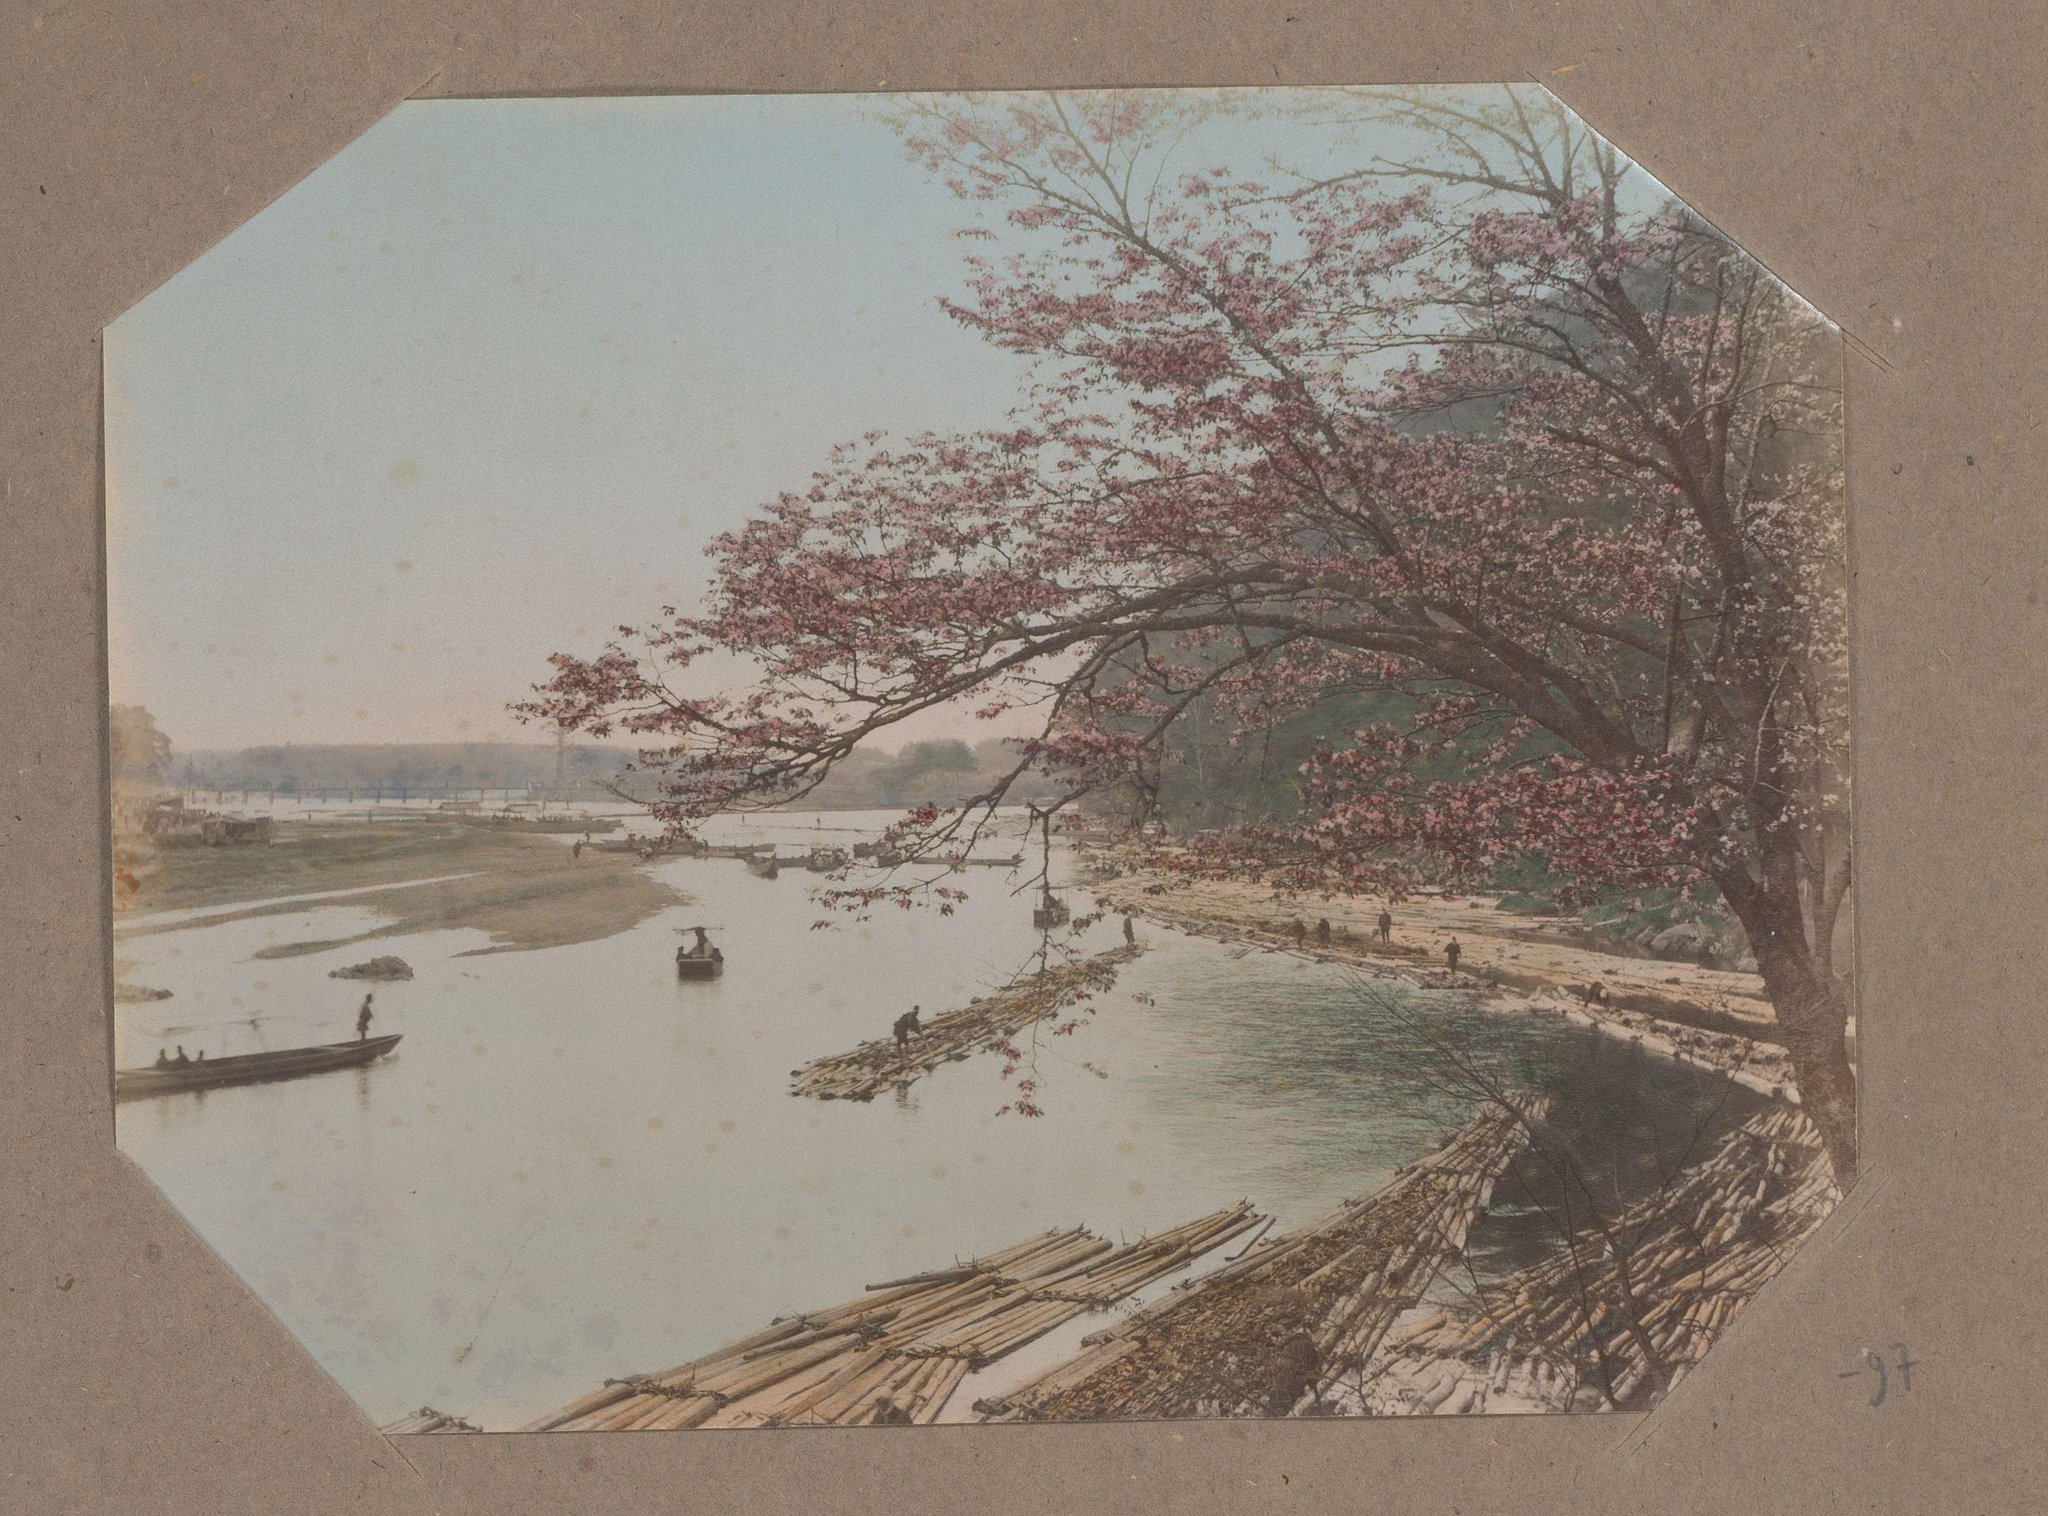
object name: photograph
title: Kersenbloesem op de oever van een rivier met bamboevlotten in Japan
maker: Anonymous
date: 1890-1903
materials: paper, photographic support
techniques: albumen print, hand coloring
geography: japan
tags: trees: cherry-tree, traffic on the water, river bank (+ landscape with figures, staffage), japan